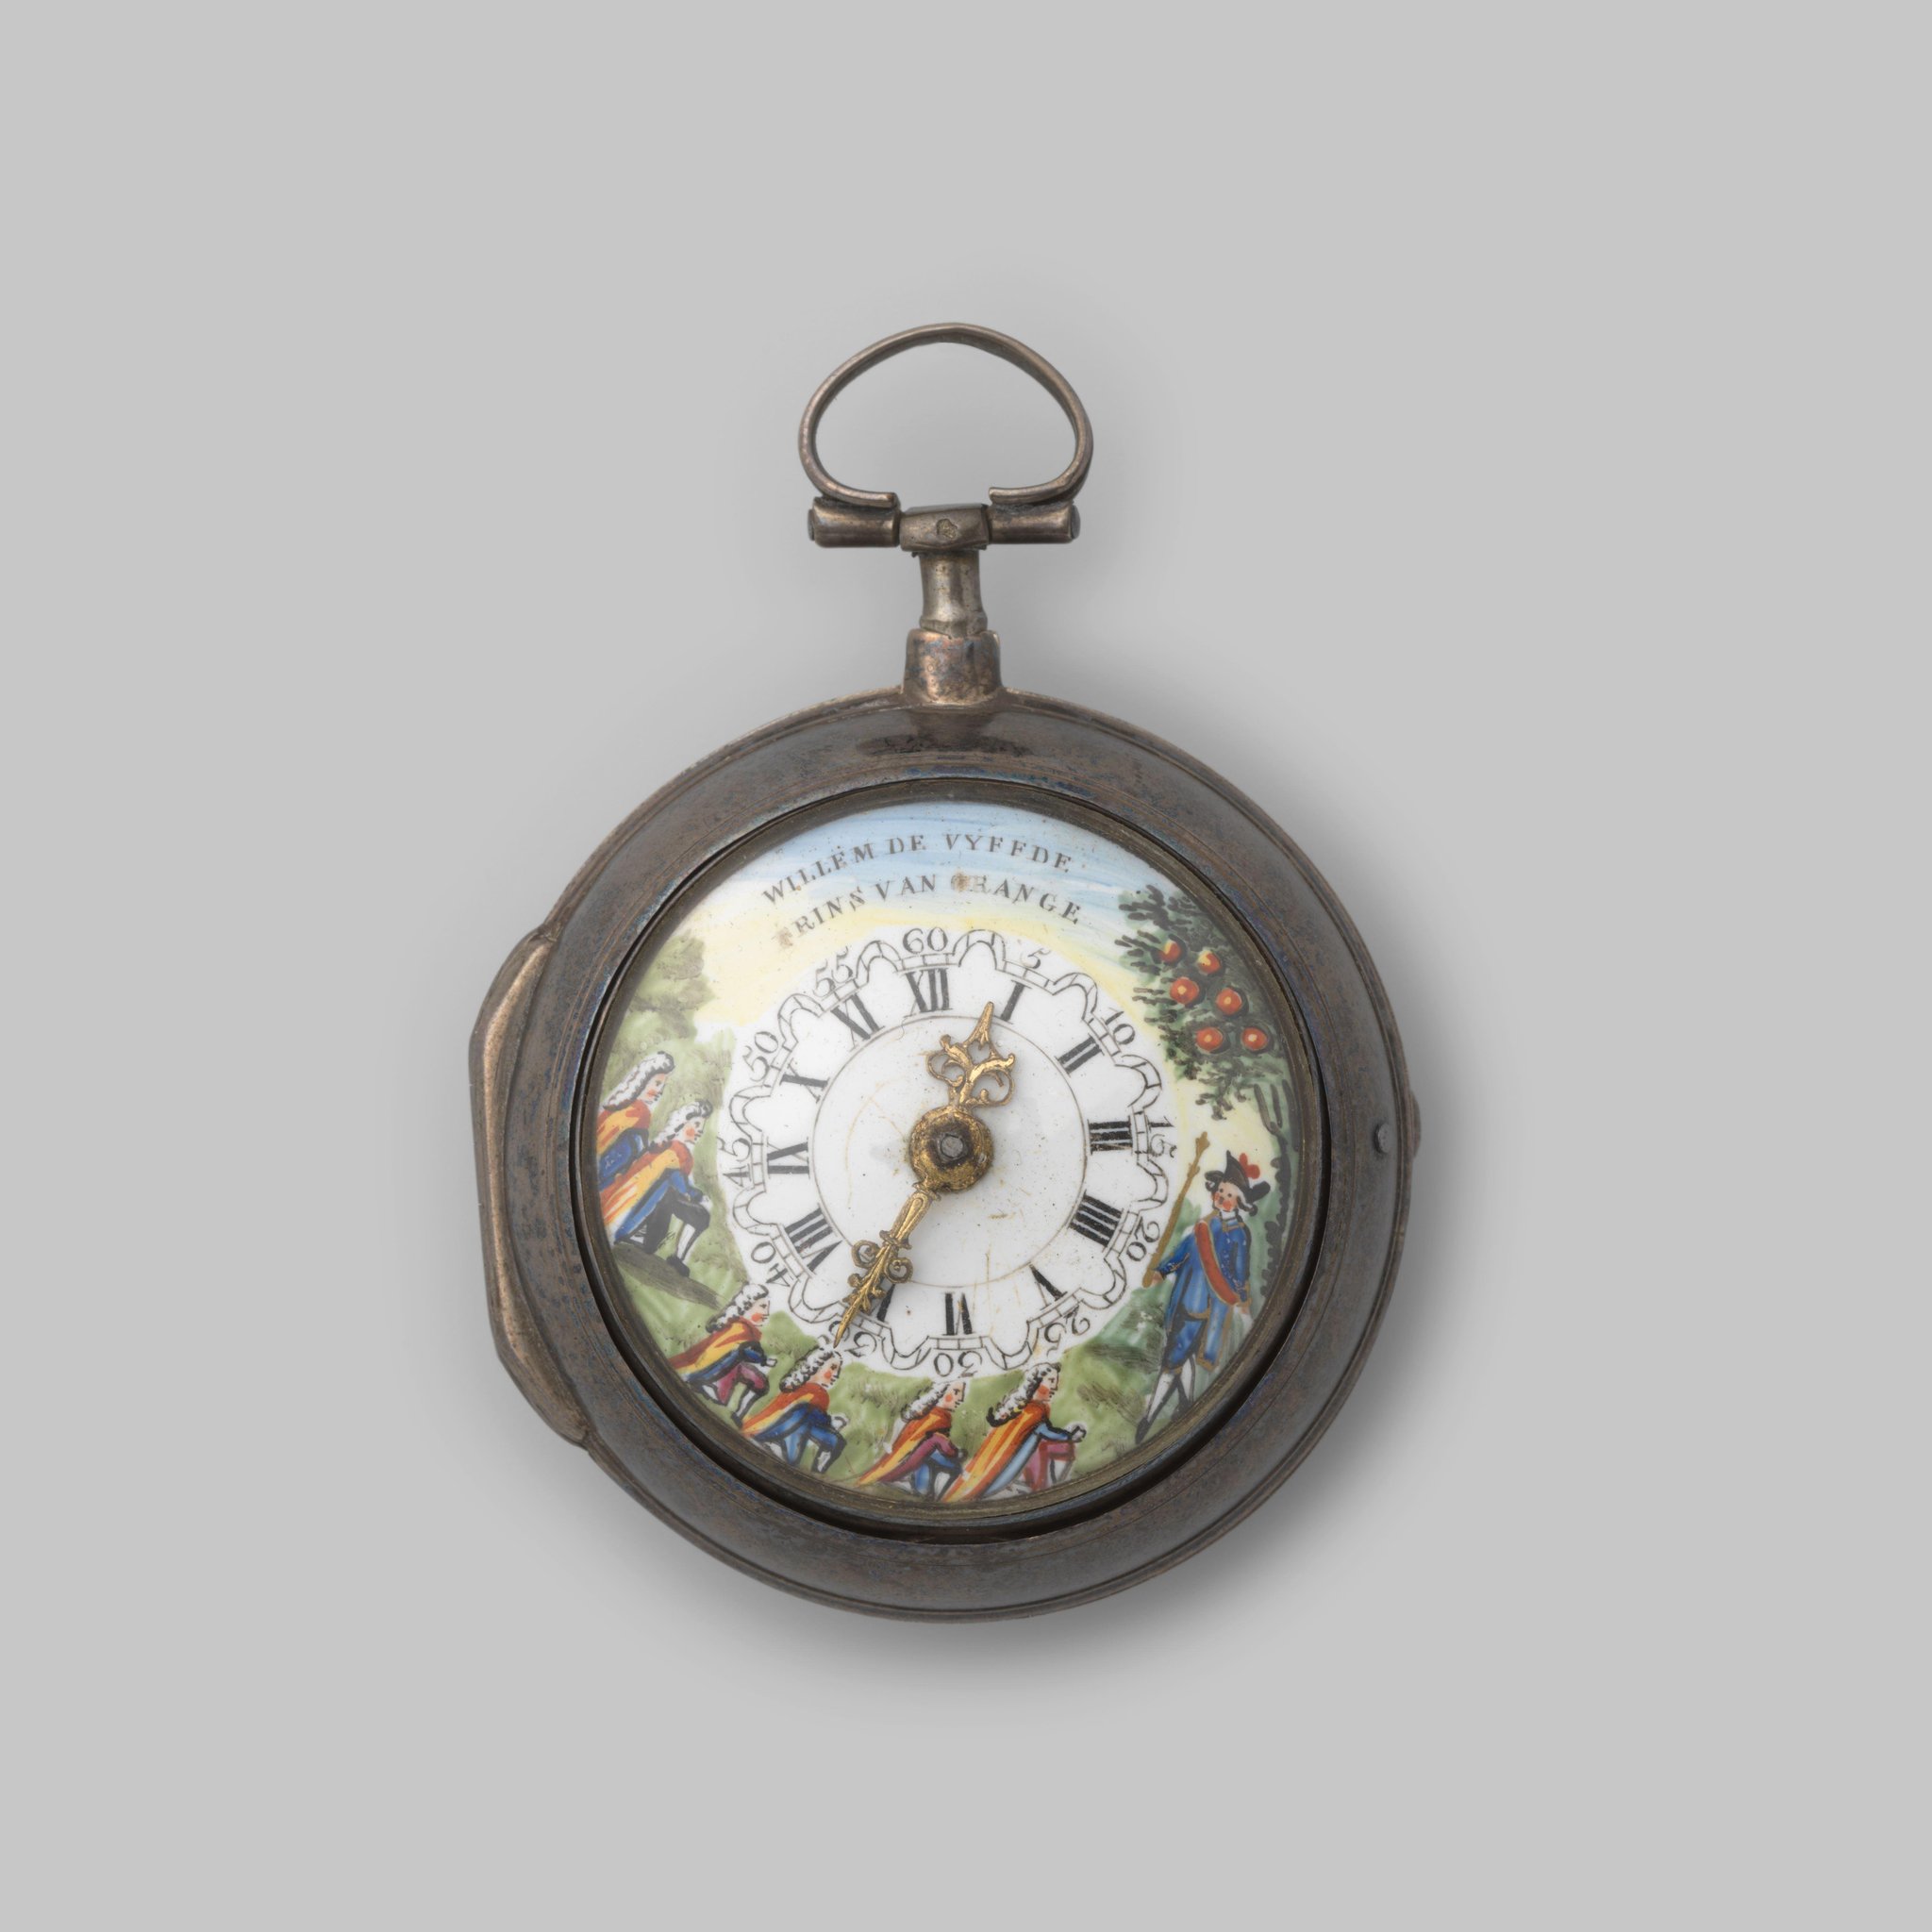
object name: jewellery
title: Herenhorloge van zilver met dubbele onversierde kast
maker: j. wilders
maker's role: clockmaker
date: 1400-1950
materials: silver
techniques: enameling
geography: london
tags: the hague, william v (prince of orange)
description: Herenhorloge van zilver met dubbele onversierde kast. Op de wijzerplaat een geëmailleerd tafereel, voorstellende Prins Willem V onder een oranje-boom.